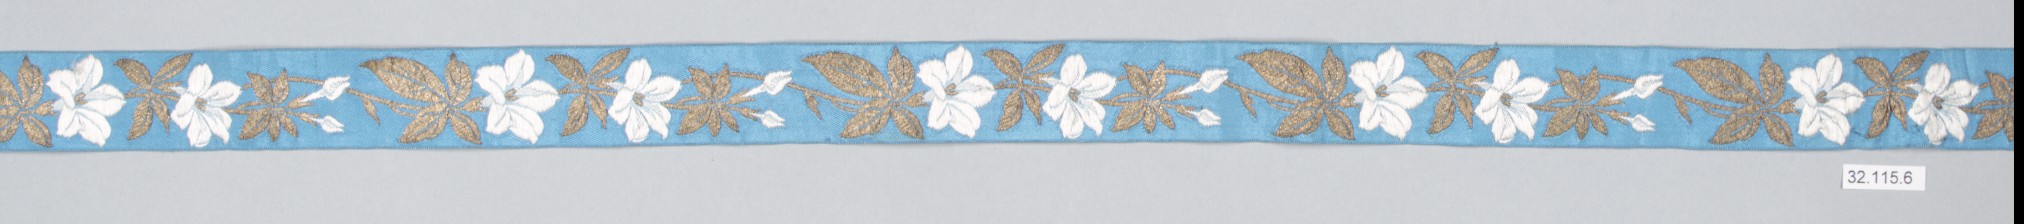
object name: ribbon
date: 1860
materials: metal thread, silk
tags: flowers